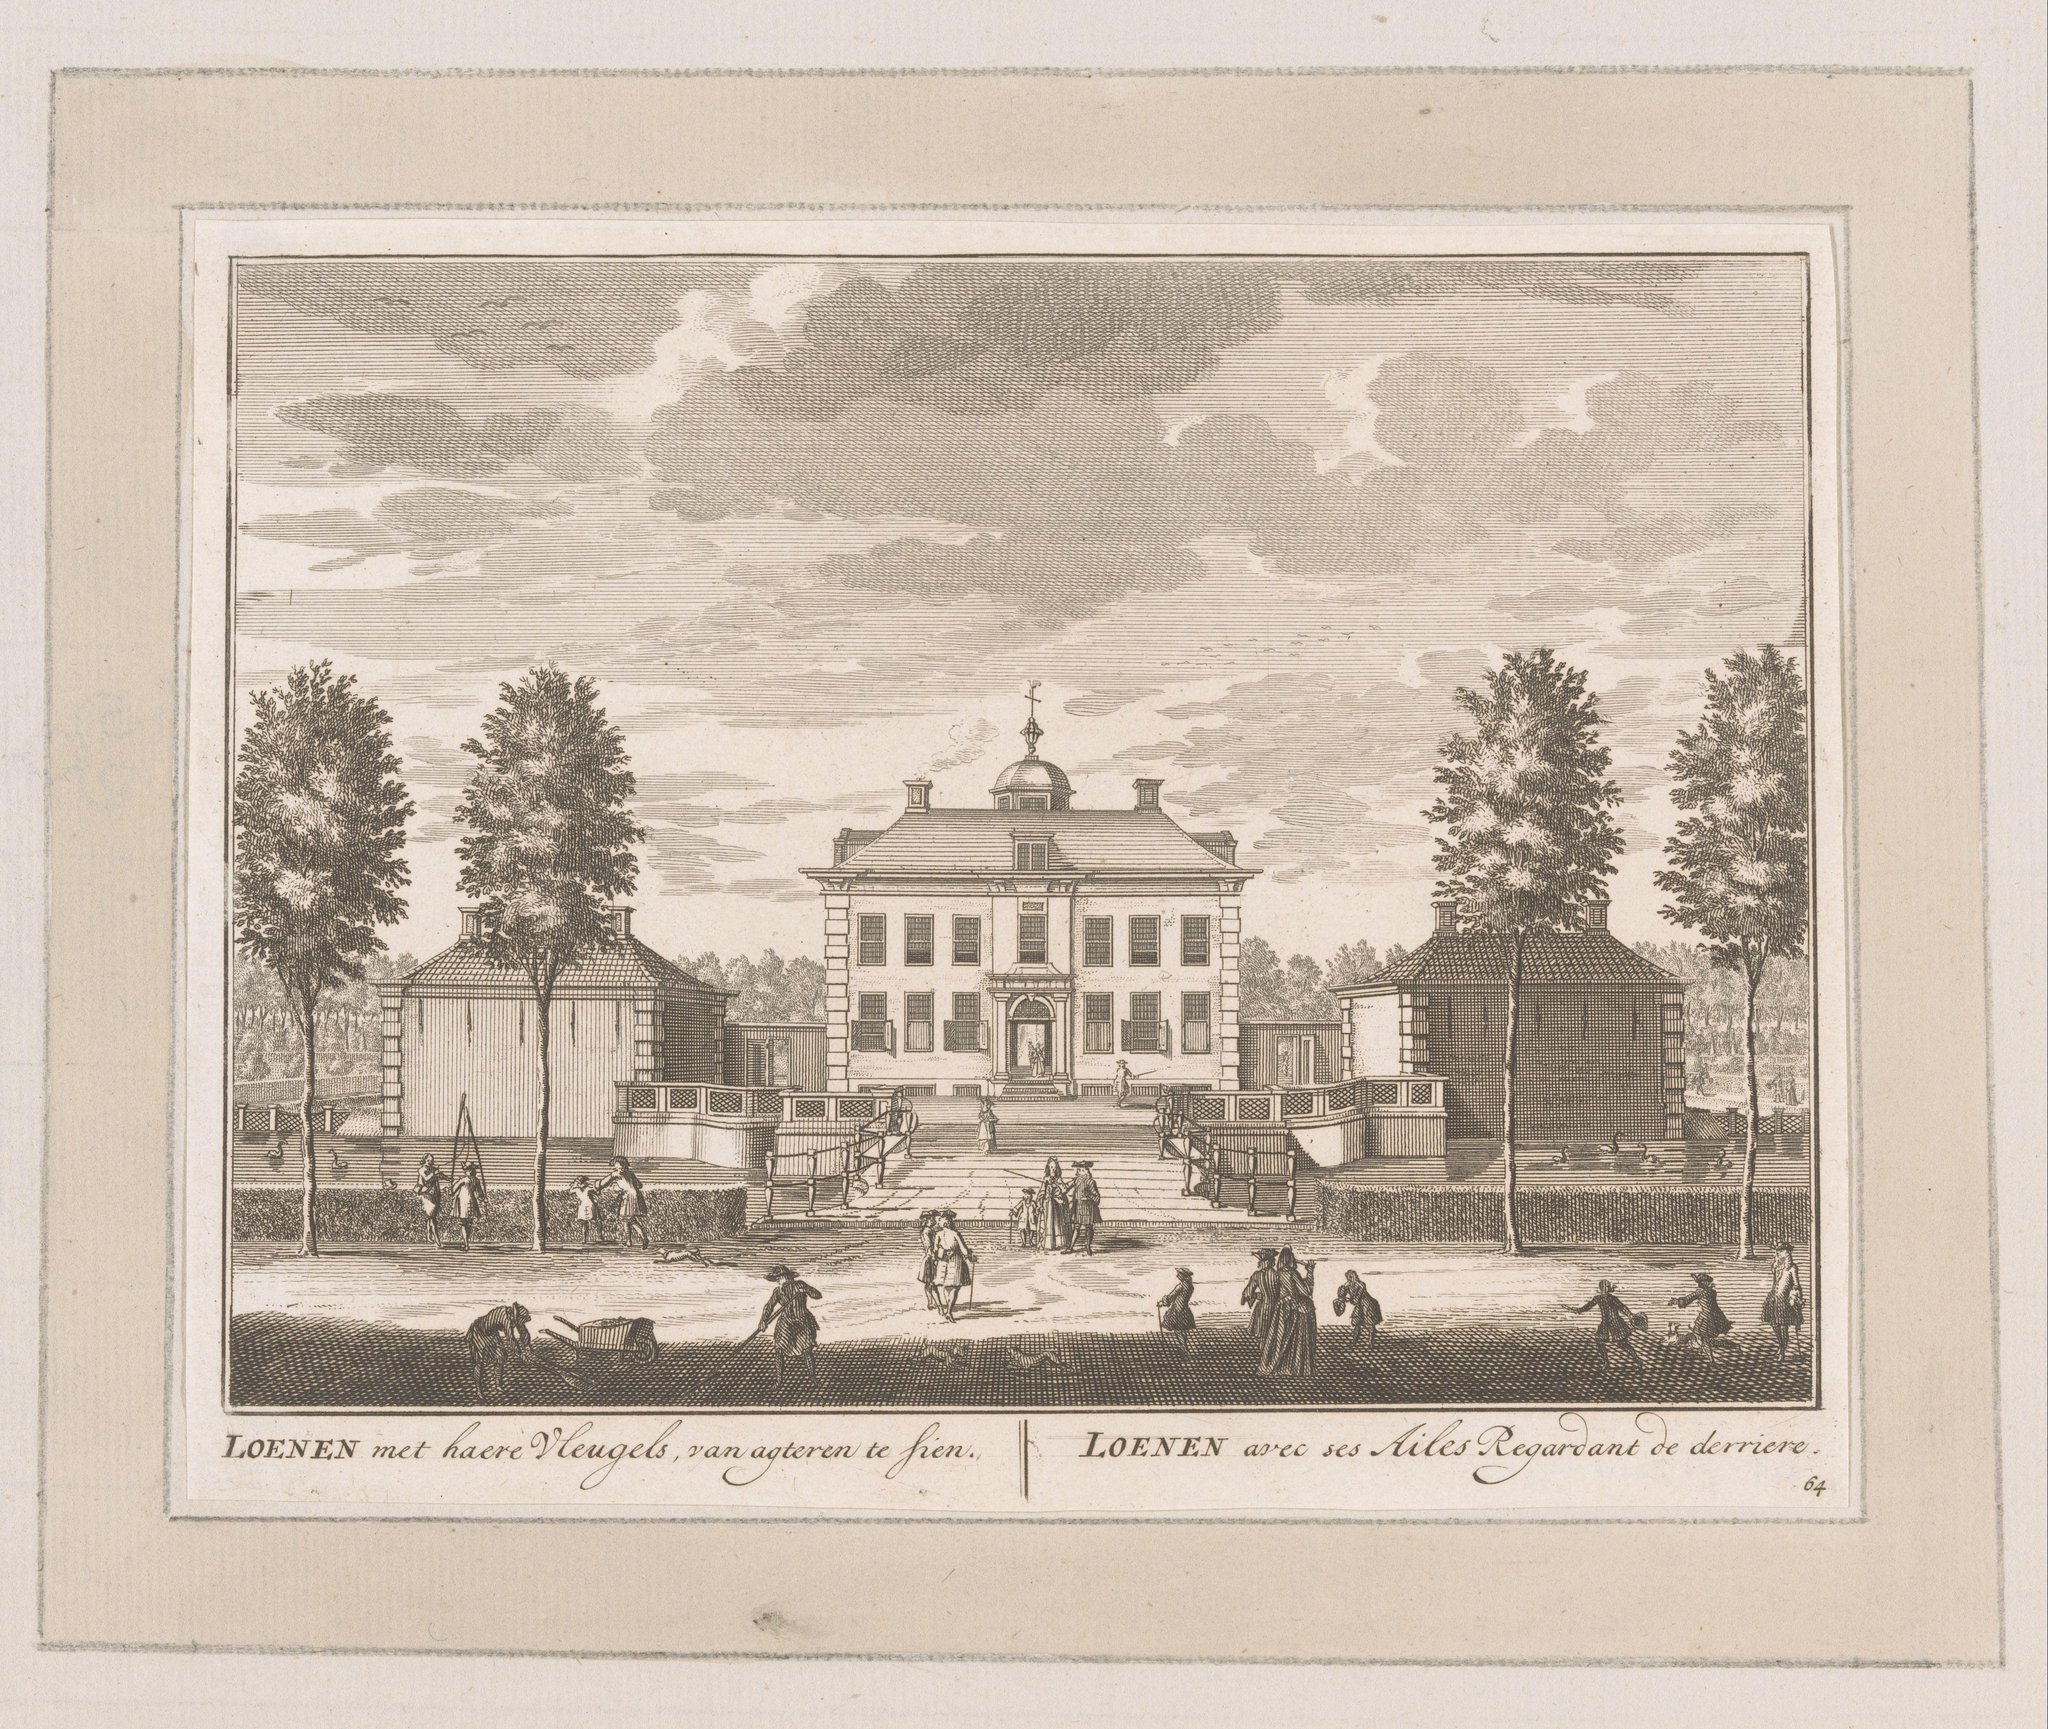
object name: print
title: Loenen met haere Vleugels, van agteren te sien / Loenen avec ses Ailes Regardant de derriere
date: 1719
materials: paper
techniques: etching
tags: river, rural housing, e.g. country-house, villa, cottage, vecht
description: Prent uit: De zegepraalende Vecht, vertoonende verscheidene gesichten van lustplaatsen, heeren huysen en dorpen, beginnende van Uitrecht en met Muyden besluytende. Amsterdam: Wed. Nicolaes Visscher, 1719.